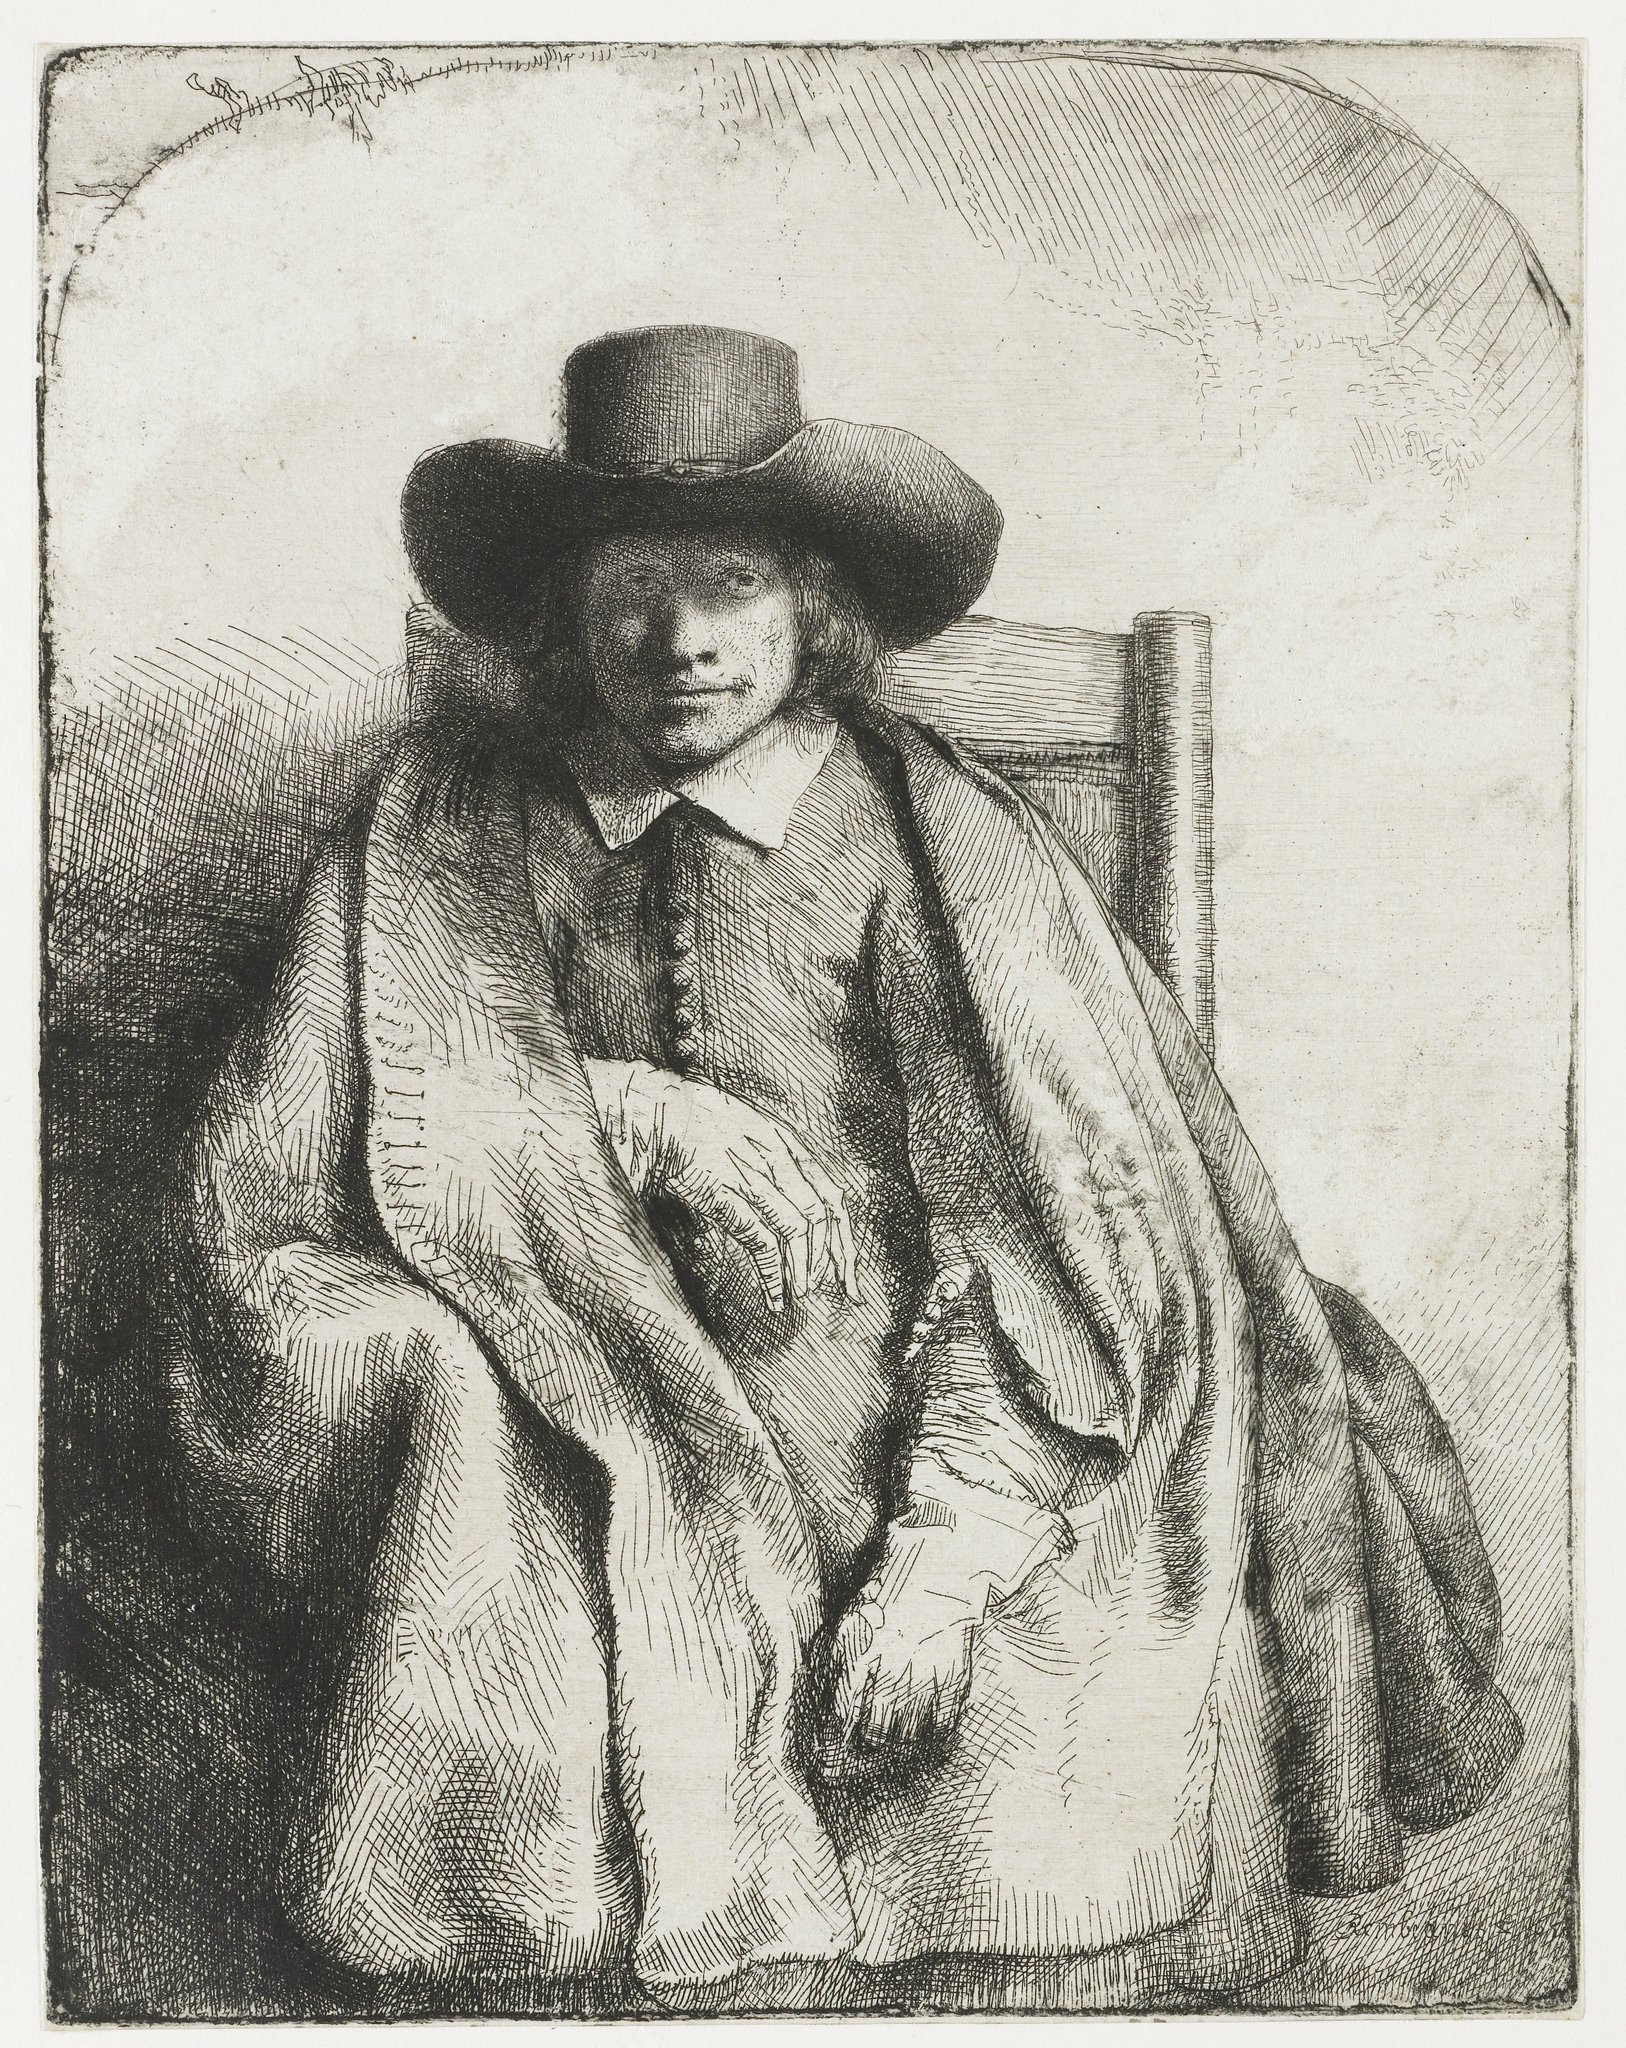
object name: print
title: Clement de Jonghe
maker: rembrandt van rijn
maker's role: draughtsman, painter, print maker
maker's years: 1606-1669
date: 1651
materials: paper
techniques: drypoint, etching, intaglio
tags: germany, amsterdam, print maker, publisher, clement de jonghe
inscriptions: collector's mark: Lugt 240, signature and date: ‘Rembrandt f 1651’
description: Rembrandt captures the features of Clement de Jonghe here with loose, sketchy lines. This Amsterdam print publisher lived in the Waag, a mere stone’s throw from Rembrandt’s house. The portrait’s informal character suggests they might have been friends. Soon after, De Jonghe acquired 74 of Rembrandt’s etching plates, cashing in on impressions that he pulled from them.